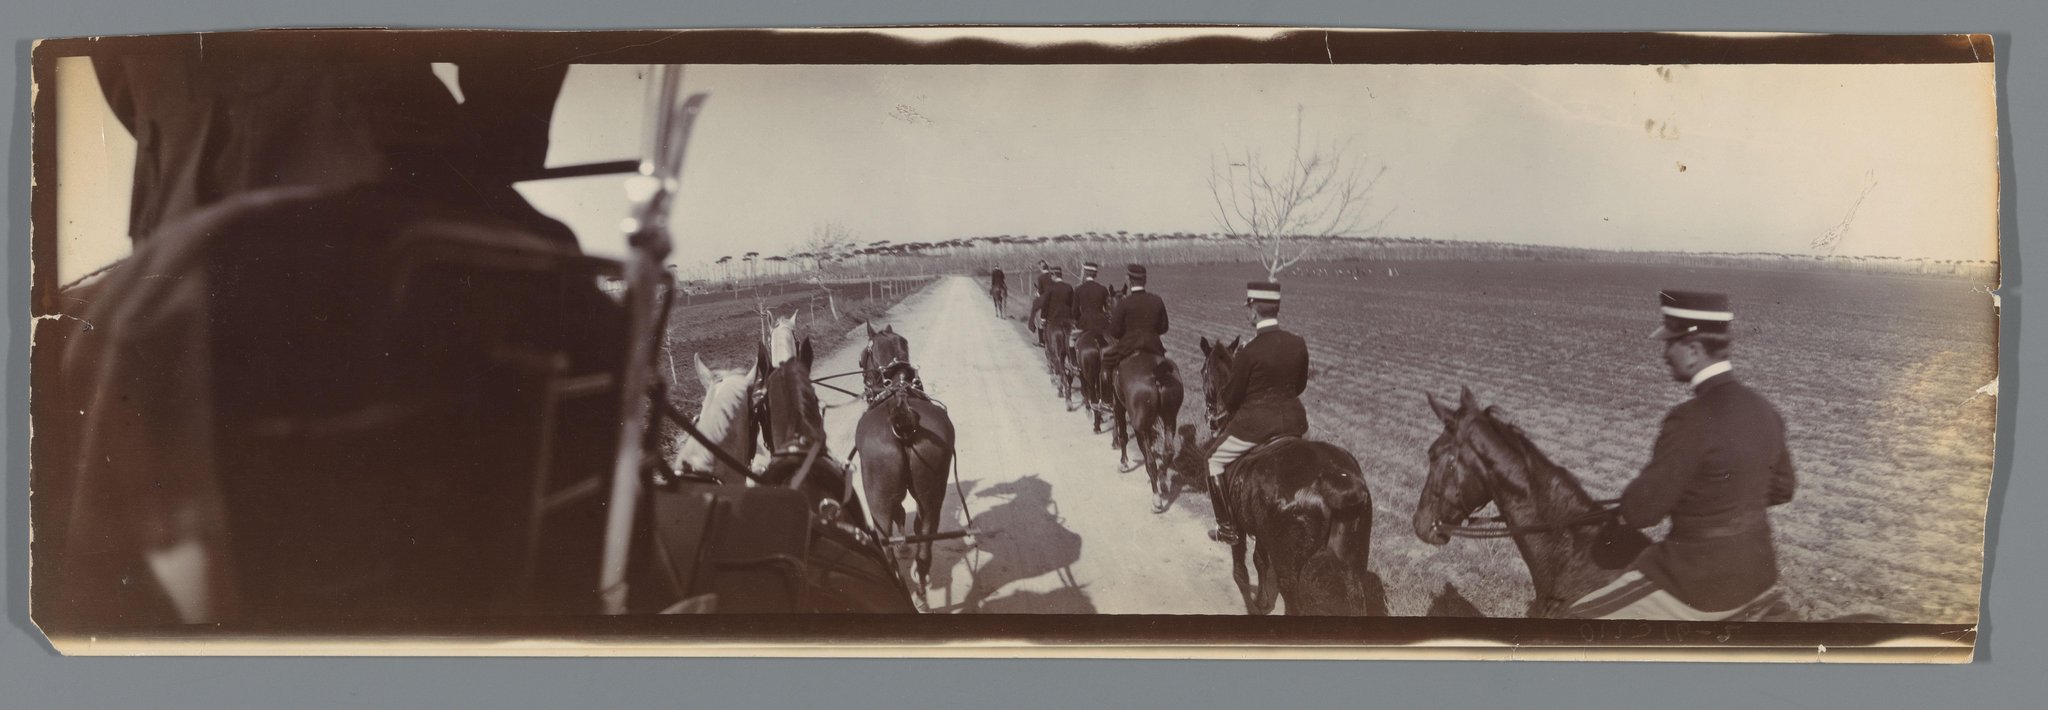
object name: photograph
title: Panoramafoto: gezicht vanaf een koets met paarden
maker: Anonymous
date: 1900-1910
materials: photographic support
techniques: gelatin silver print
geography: france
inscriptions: inscription: ‘10 / IJ [?]’